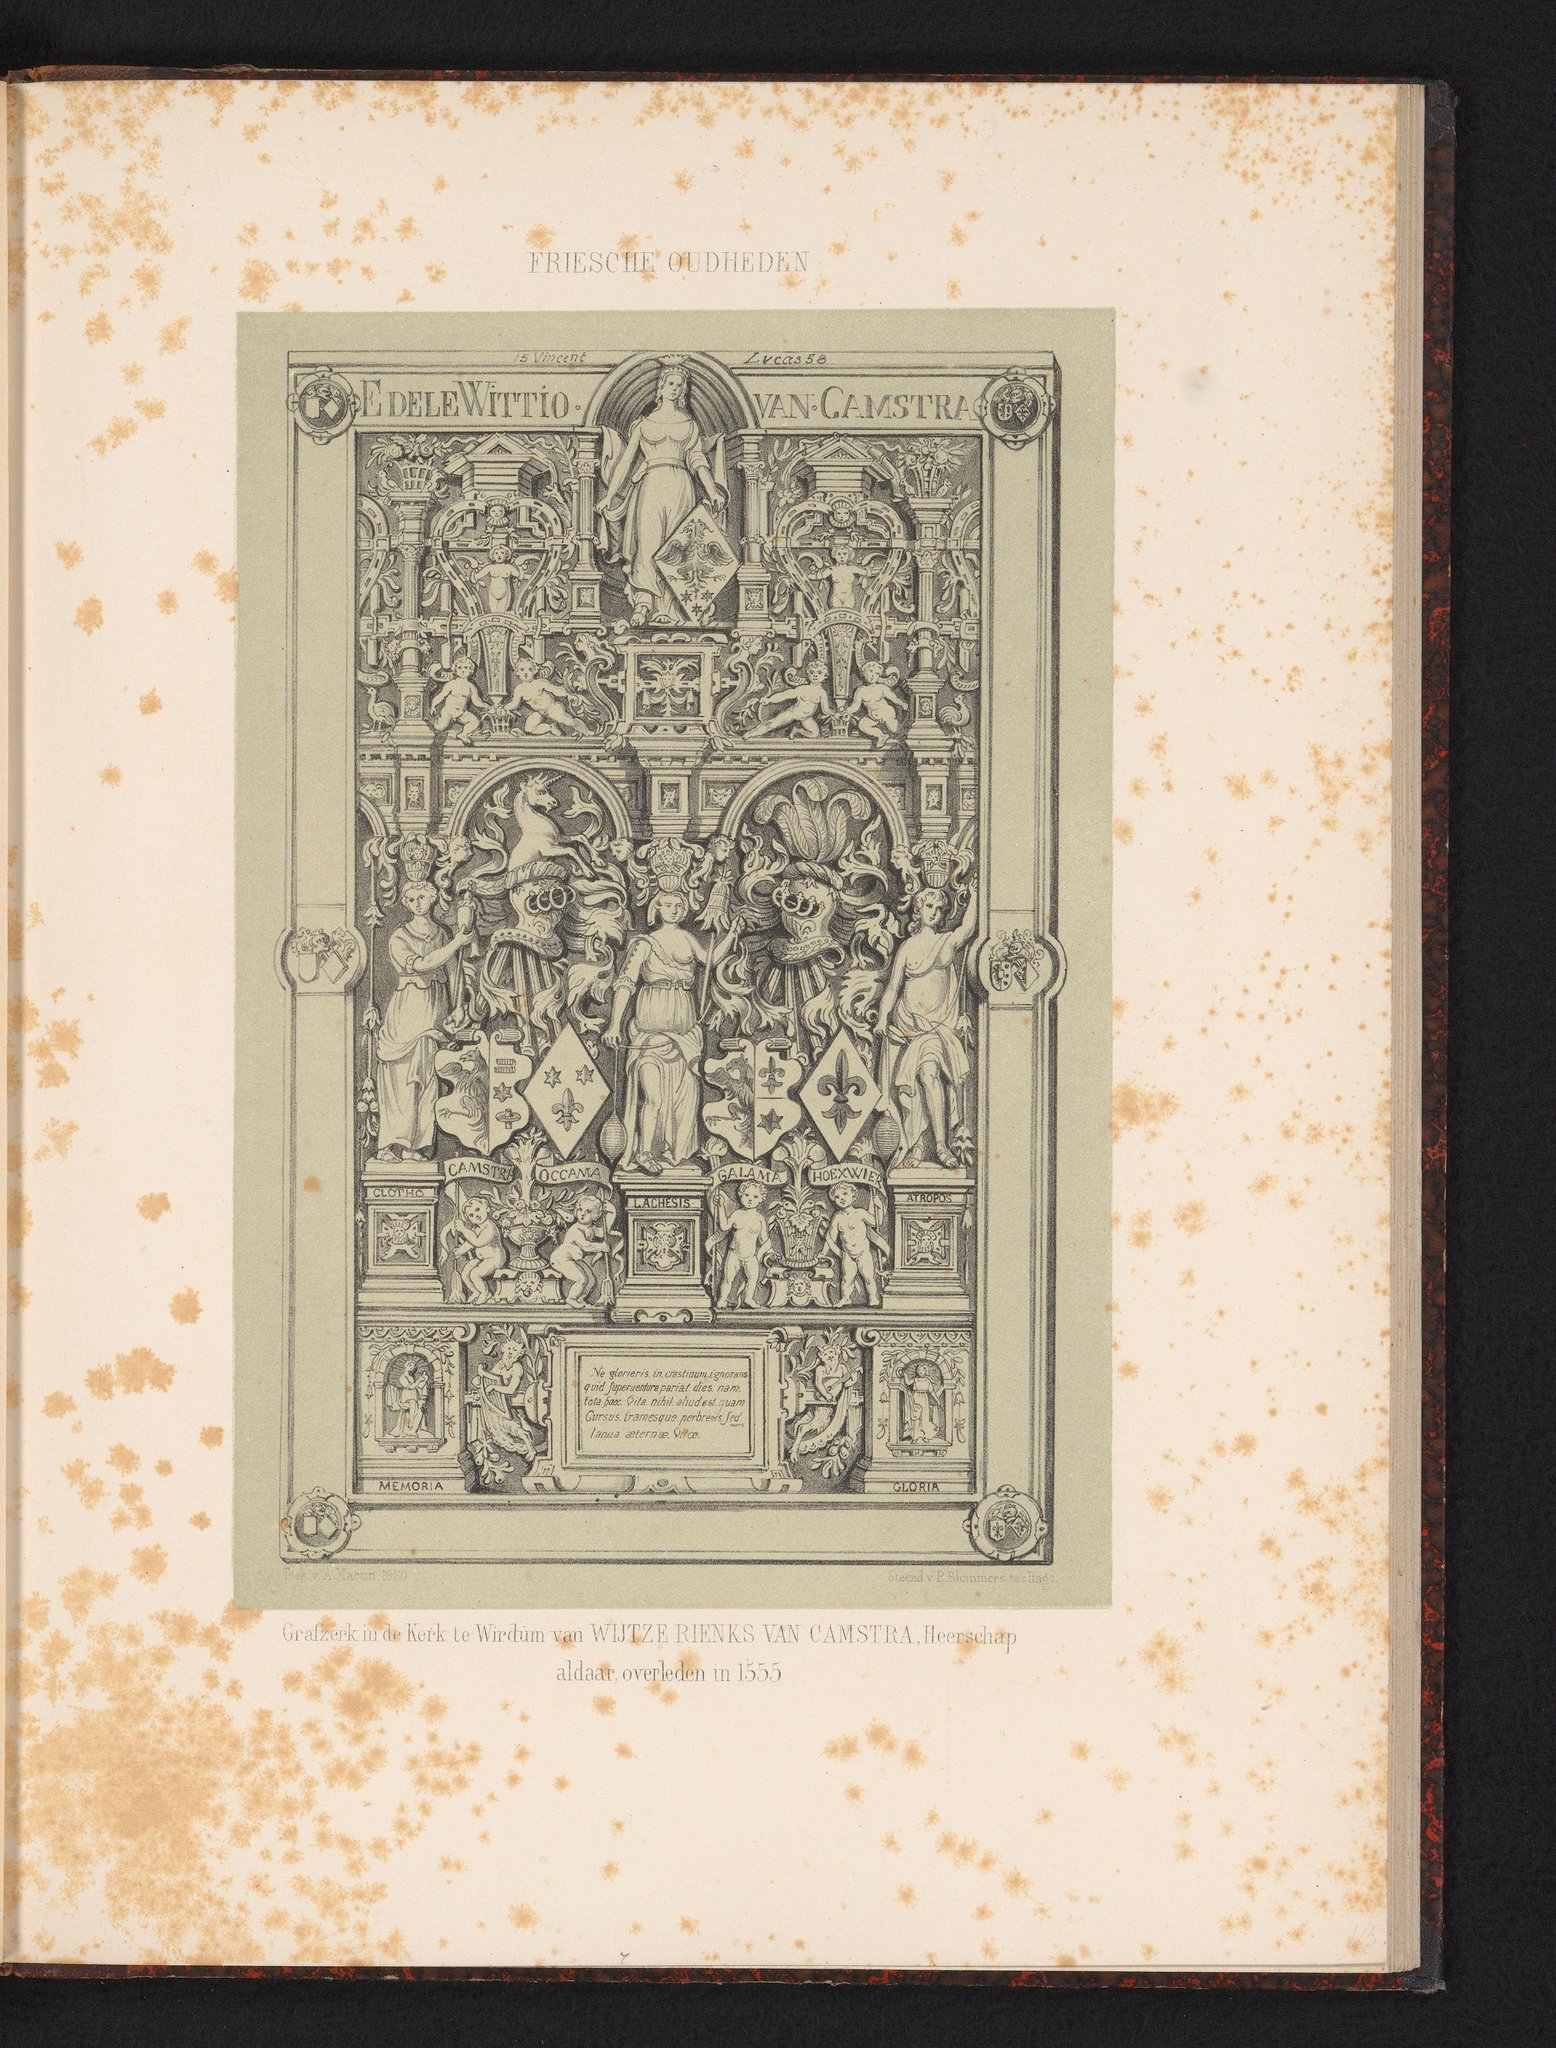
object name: historical object representation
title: Grafzerk in de Kerk te Wirdum van Wijtze Rienks van Camstra, Heerschap aldaar, overleden in 1555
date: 1870-1875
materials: paper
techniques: lithograph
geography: the hague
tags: grave, tomb and other grave-forms and grave-markers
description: Illustratie in: Friesche Oudheden. Afbeeldingen van merkwaardige voorwerpen van Wetenschap en Kunst, gevonden in de archieven, kerken, kasteelen, terpen enz. van Friesland, Leeuwarden 1875. Niet in Frederik Muller; door het RPK toegevoegd nummer.